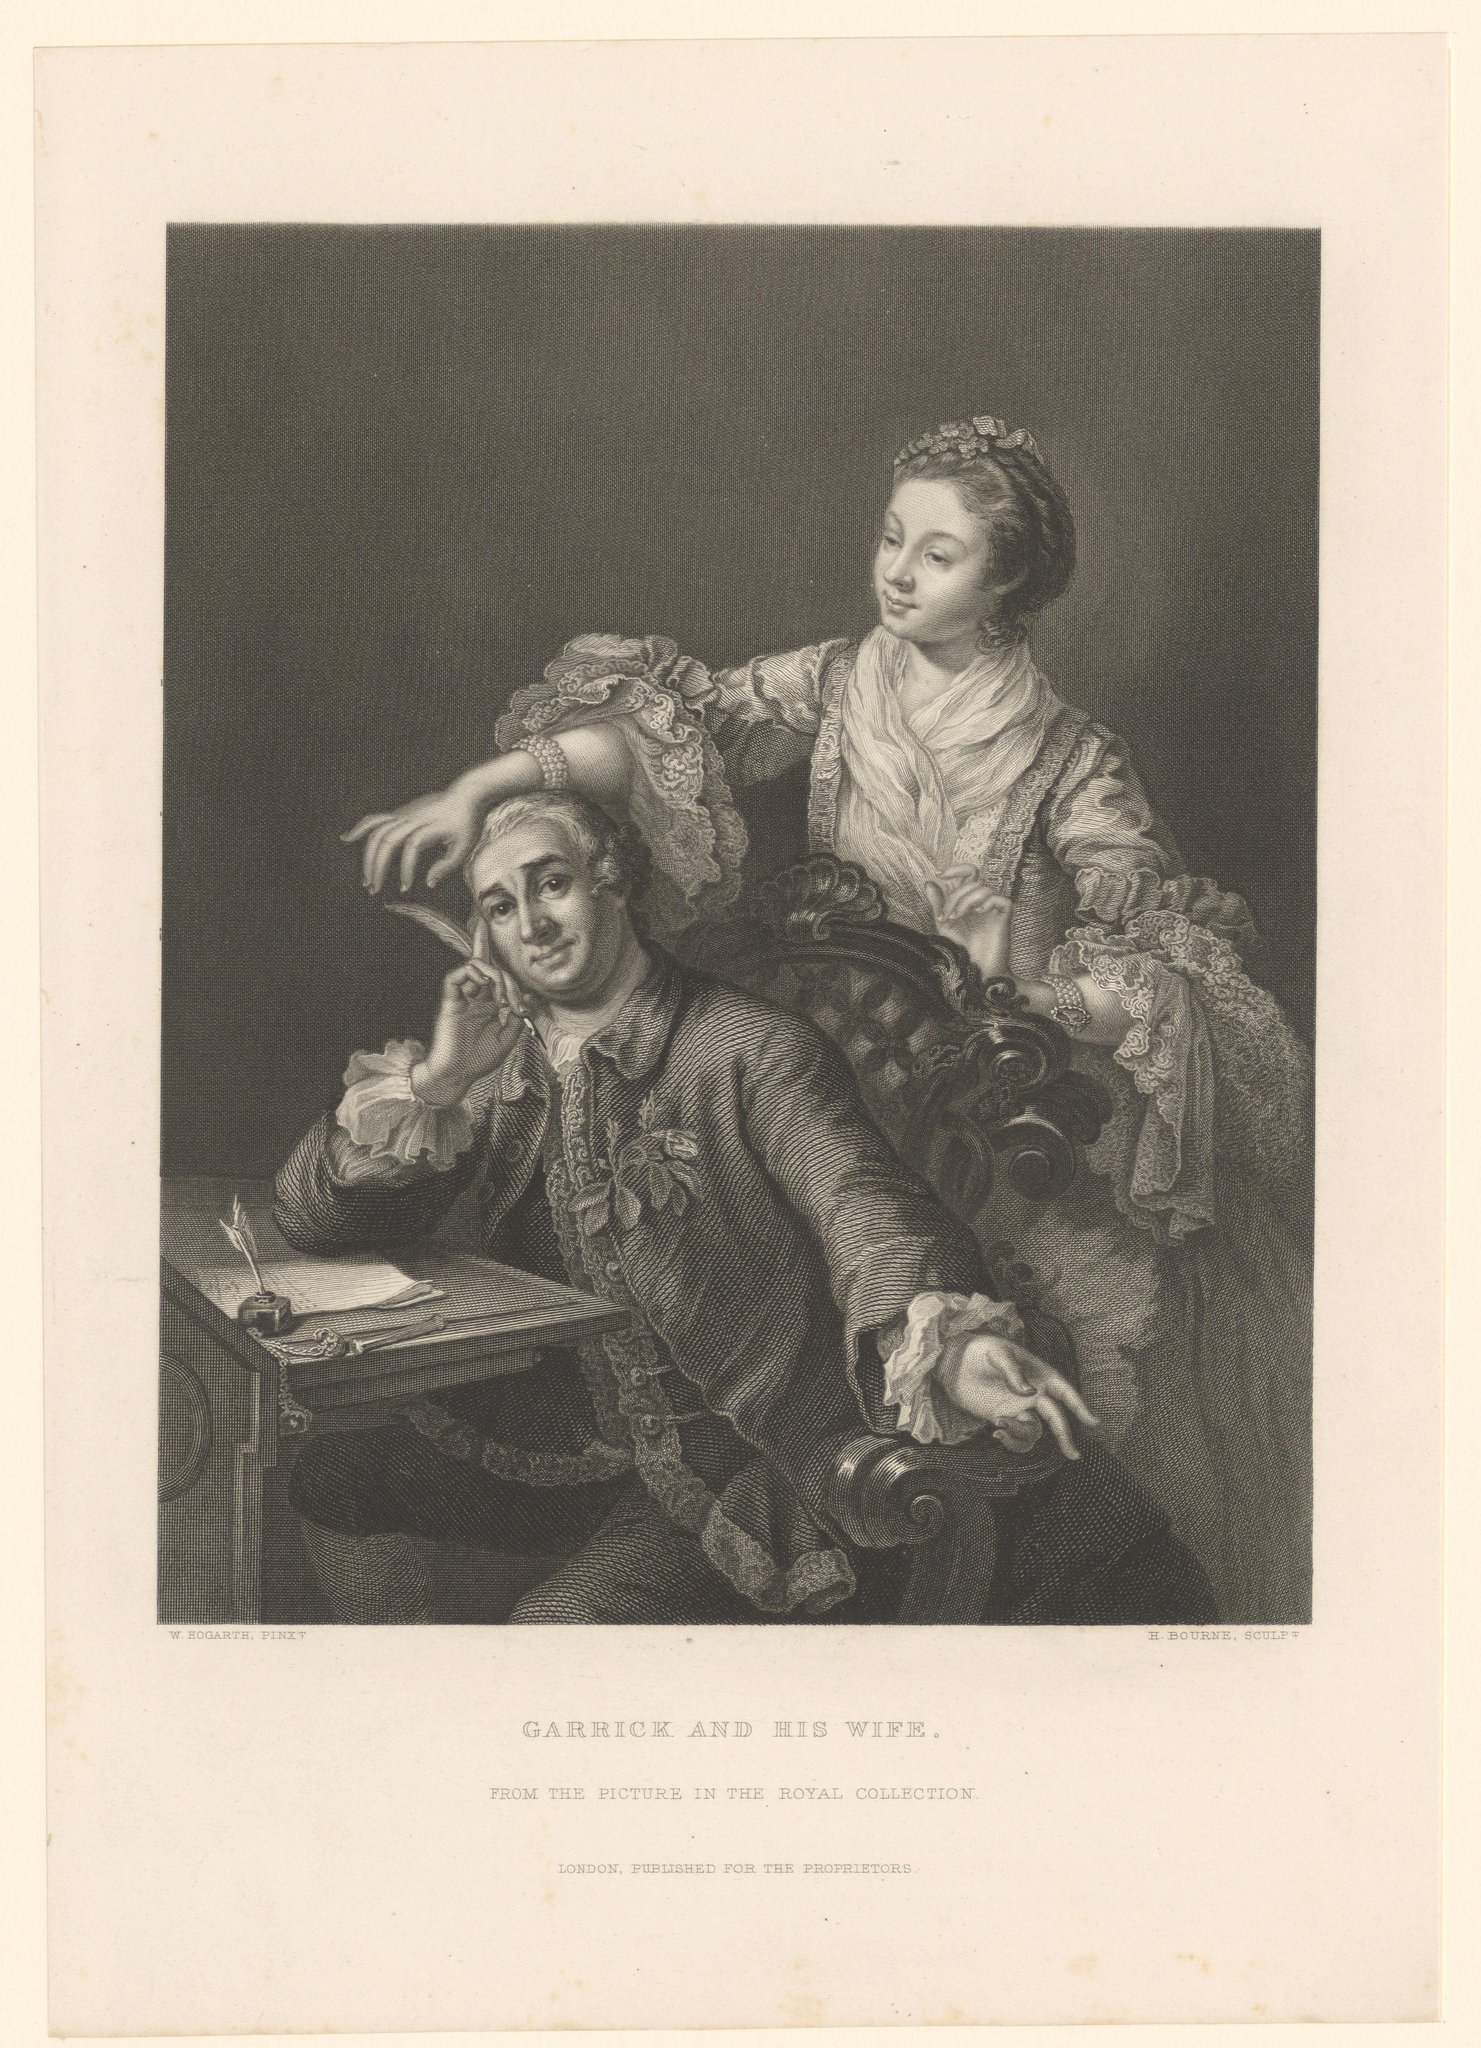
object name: print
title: Garrick and his wife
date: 1855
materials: paper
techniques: engraving, etching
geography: london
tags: david garrick, vienna, london, historical persons, portrait of actor, actress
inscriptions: collector's mark: Lugt 2228